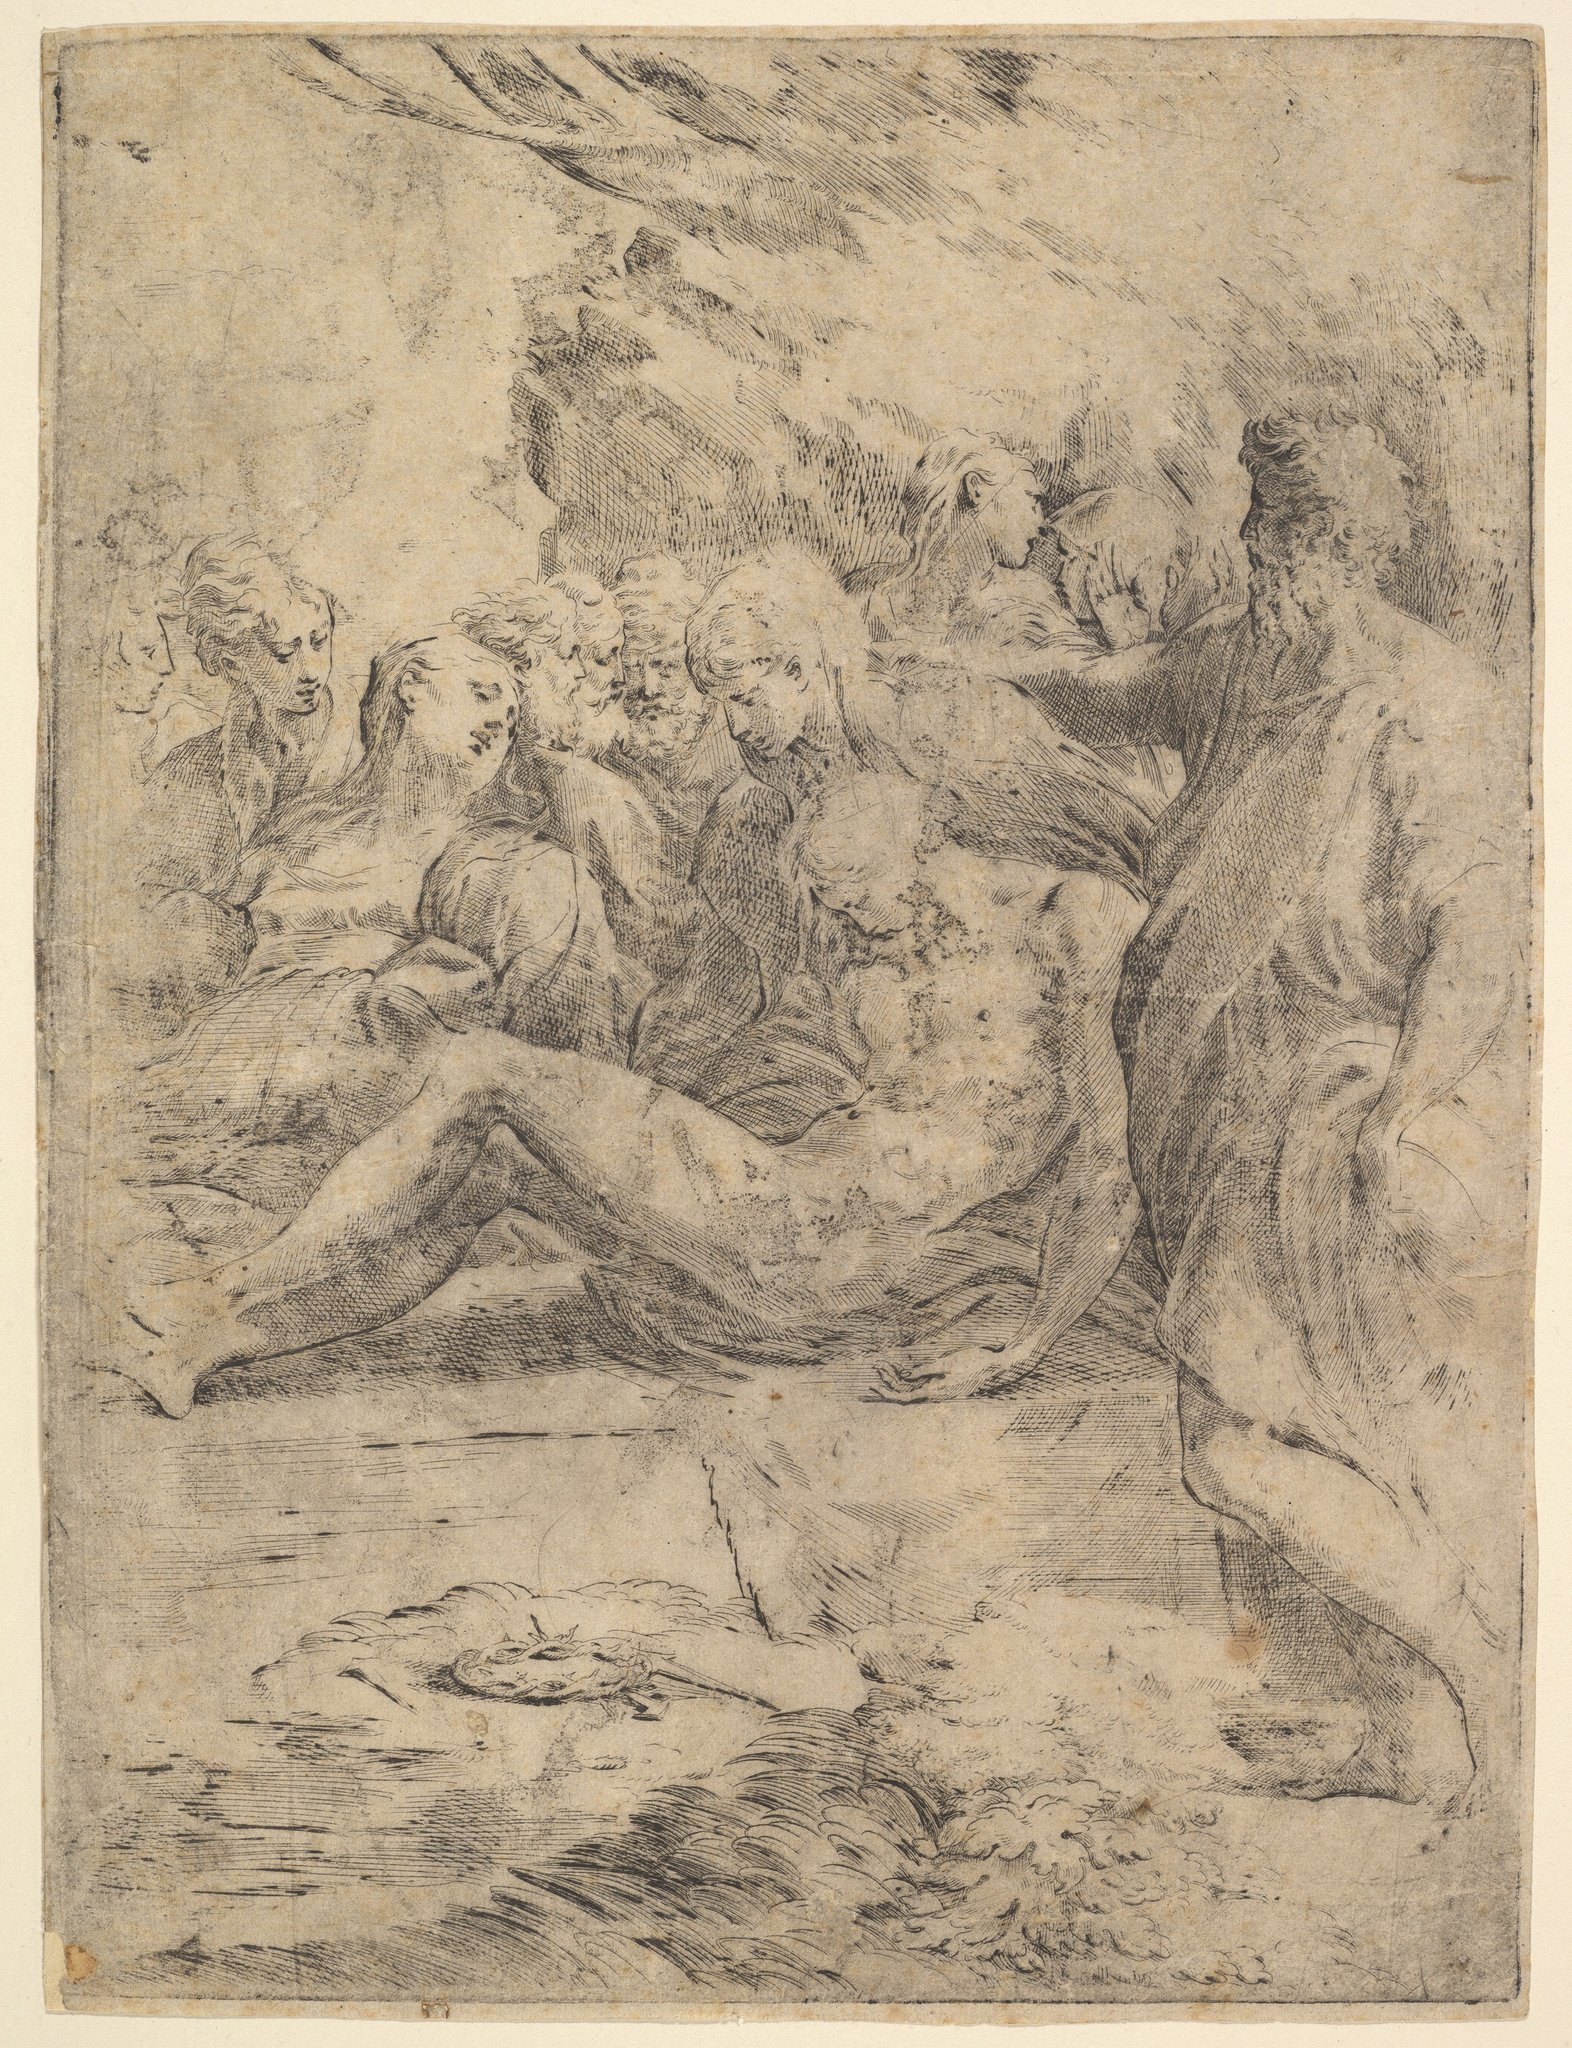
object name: print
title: Entombment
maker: anonymous, italian, 16th century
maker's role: artist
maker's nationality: italian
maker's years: 1500-1600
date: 1501-1600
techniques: etching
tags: sadness,christ,virgin mary,entombment